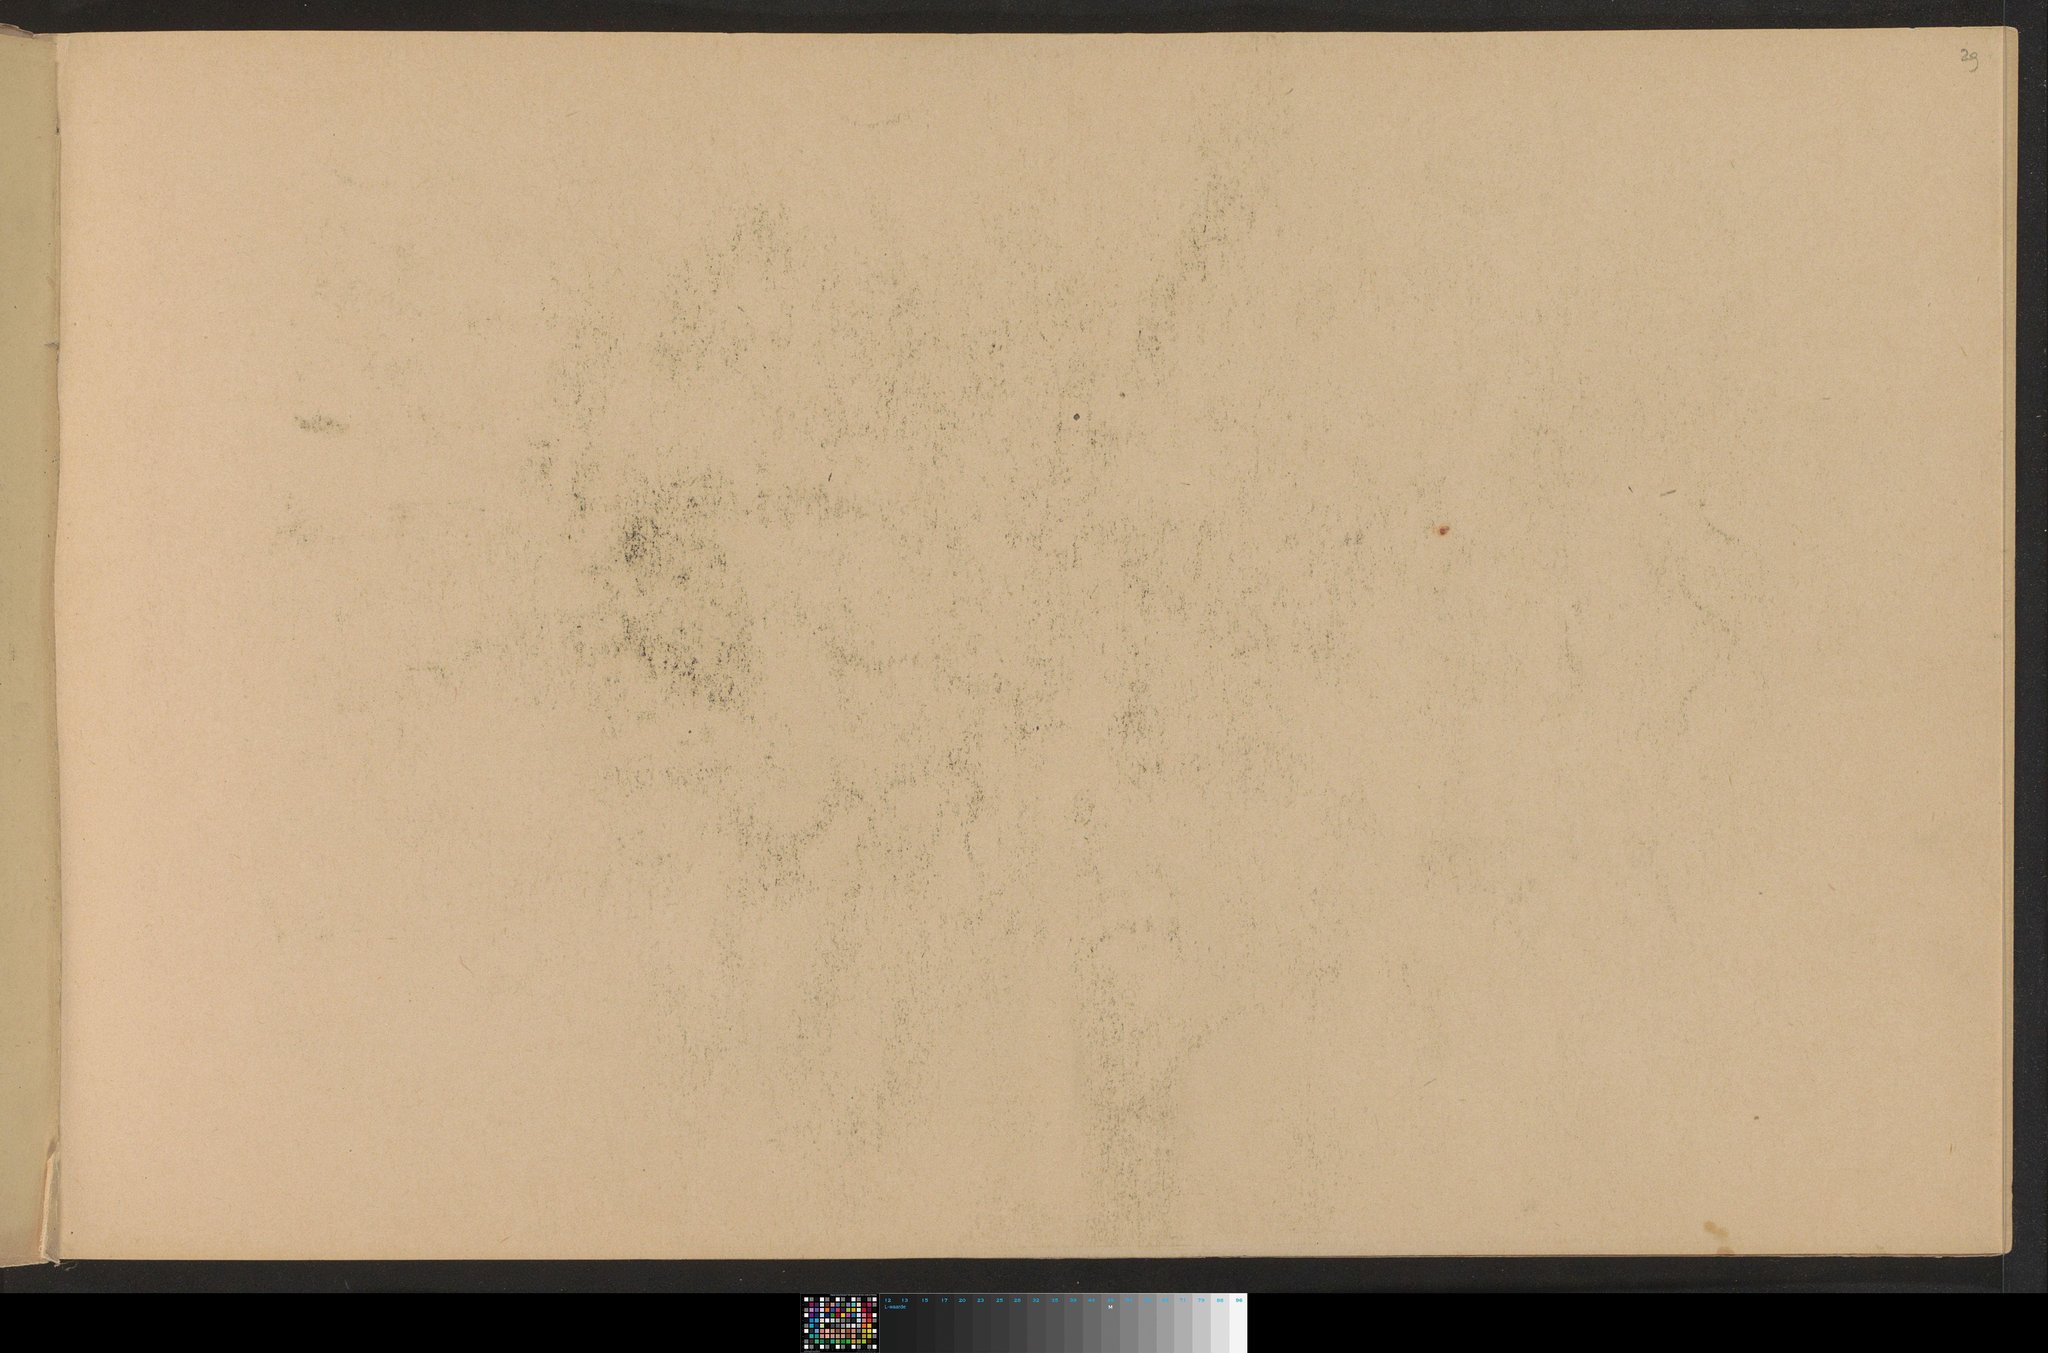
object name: sketchbook leaf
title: Abklatsch van de krijttekening op pagina 28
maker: willem witsen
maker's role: draughtsman, painter, print maker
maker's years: 1860-1923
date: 1897-1910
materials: paper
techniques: printmaking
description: Pagina 29 uit een schetsboek met 19 bladen.